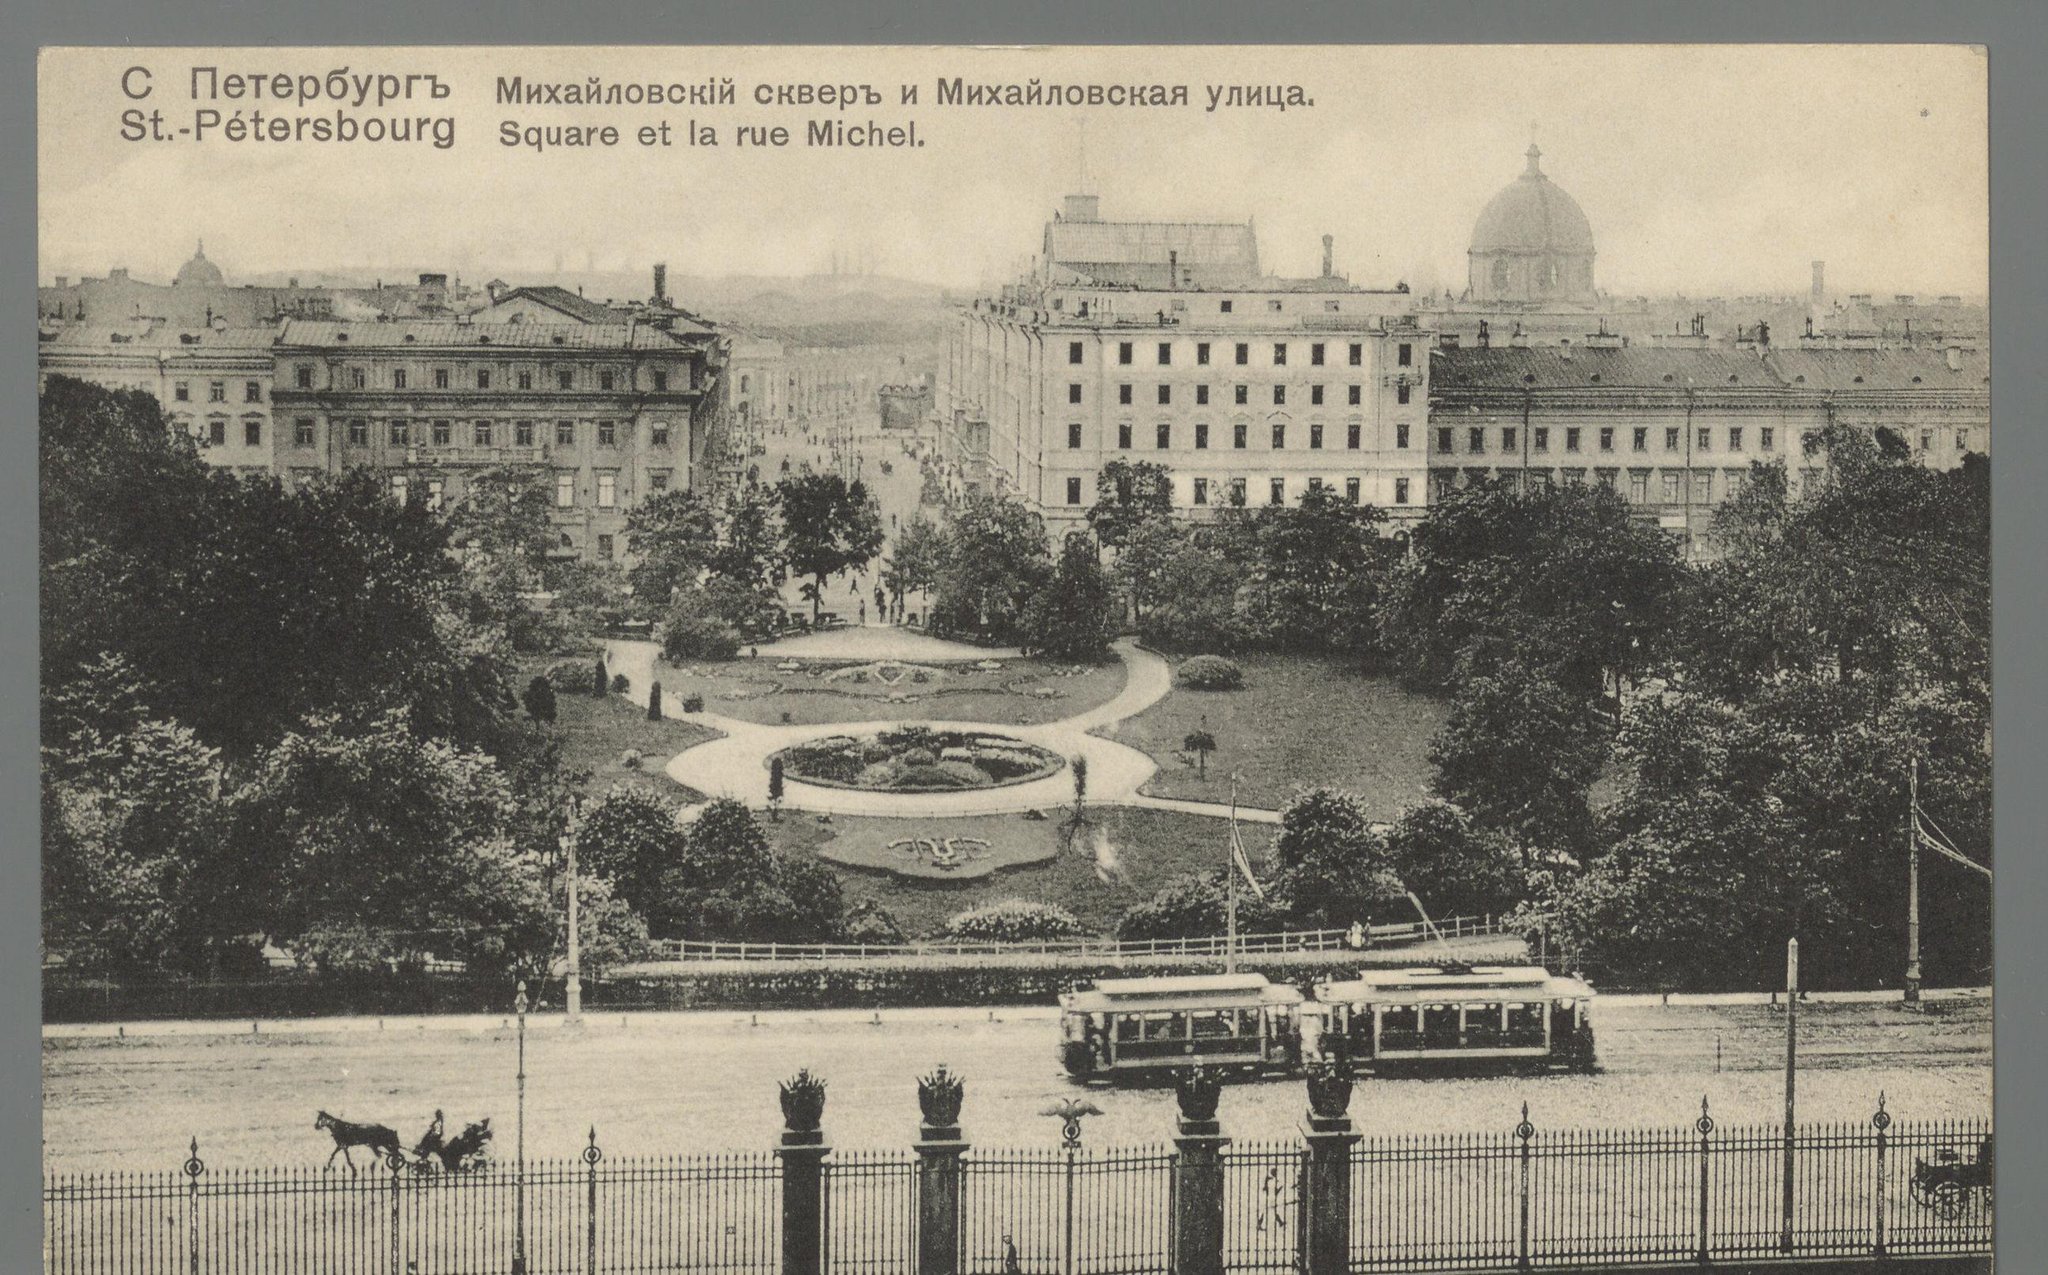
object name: ansichtkaart, prentbriefkaart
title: St.-Pétersbourg. Square et la rue Michel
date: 1904-1930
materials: cardboard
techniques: photograph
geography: sint-petersburg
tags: square, place, circus, etc., tram, street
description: Boven de Franse titel staat de titel in het Russisch.